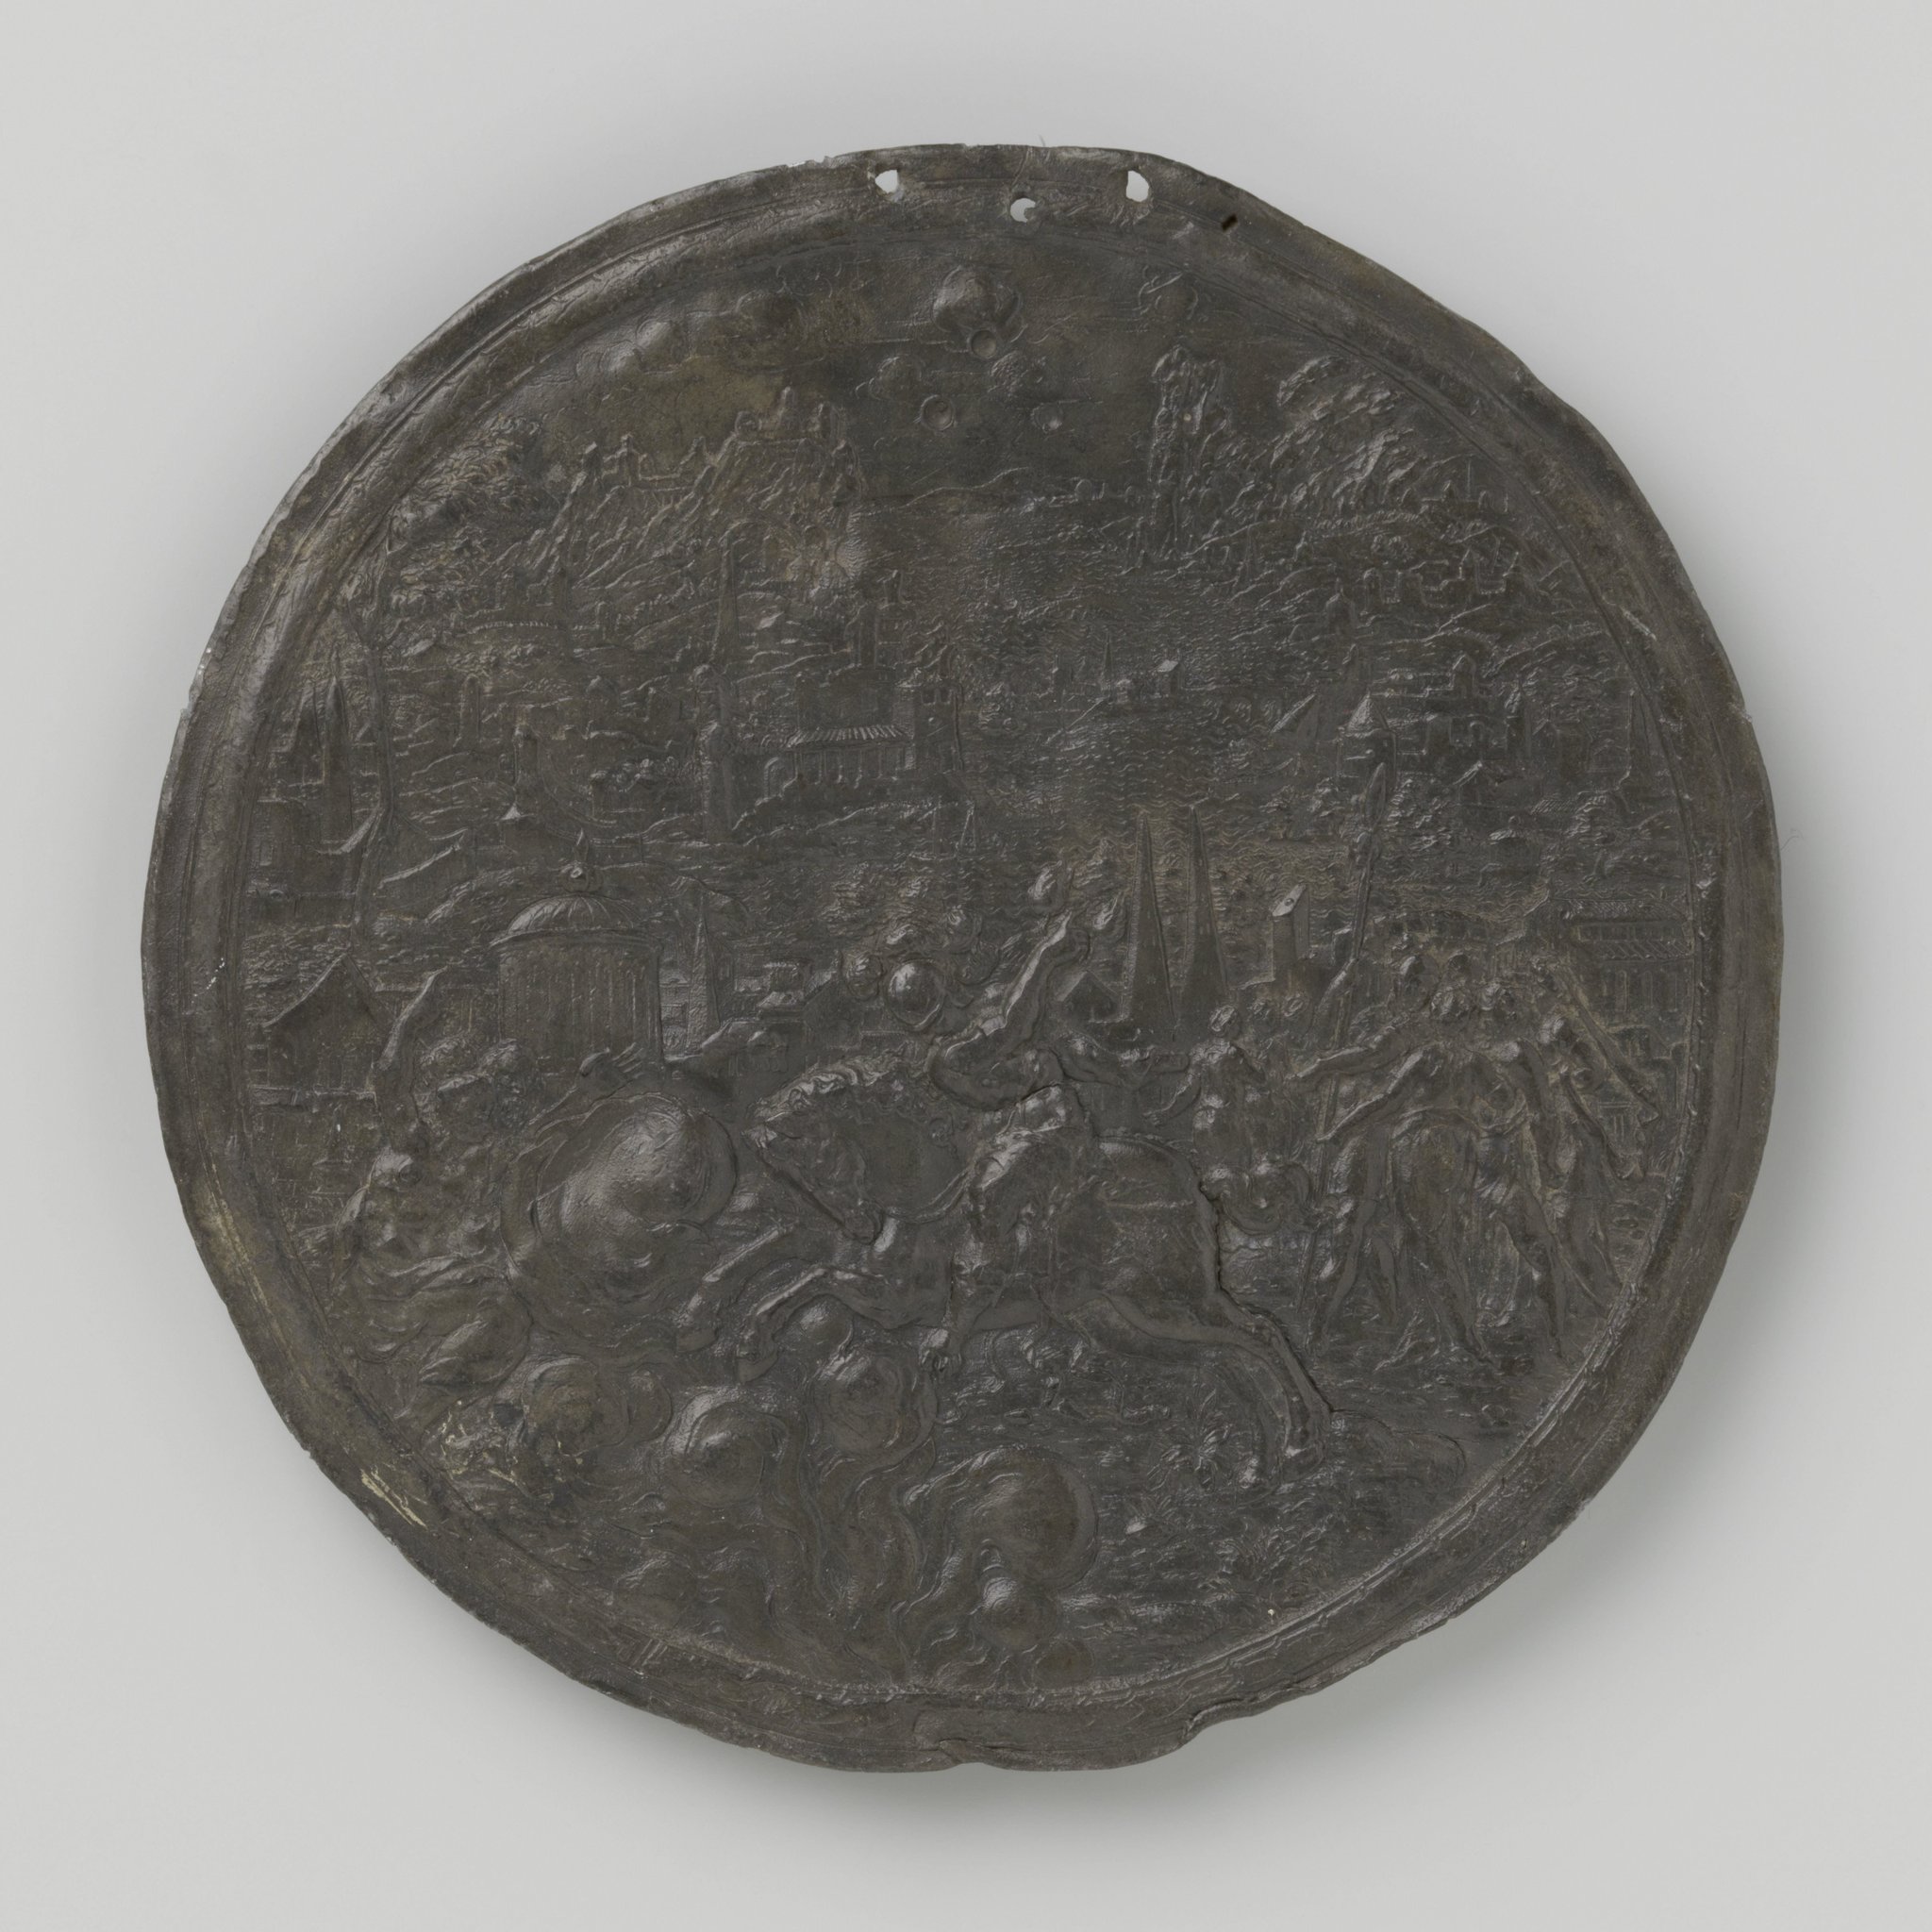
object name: plaque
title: Marcus Curtius' dood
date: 1600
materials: lead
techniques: casting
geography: netherlands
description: Ronde, loden plaquette, omgeven door een bladrand. Op de voorgrond stort de held zich te paard en in volle wapenrusting in de vurige kloof, die zich op het Forum Romanum geopend had. De wichelaars hadden voorspeld dat groot onheil over de stad zou komen, wanneer hierin niet het meest waardevolle van Rome geofferd zou worden. Marcus Curtius, die de moed der Romeinen en hun wapenen hun kostbaarste bezit achtte, bracht aldus zichzelf ten offer, waarop de kloof zich sloot. Geheel links heft een figuur de handen vol schrik omhoog; rechts een groep van vijf figuren en iets verder naar het tweede plan drie vrouwen. Veel architecturen met torens en obelisken, die de stad Rome moeten aanduiden. Op de achtergrond fantastische bergenter weerszijden van een overbrugde rivier.